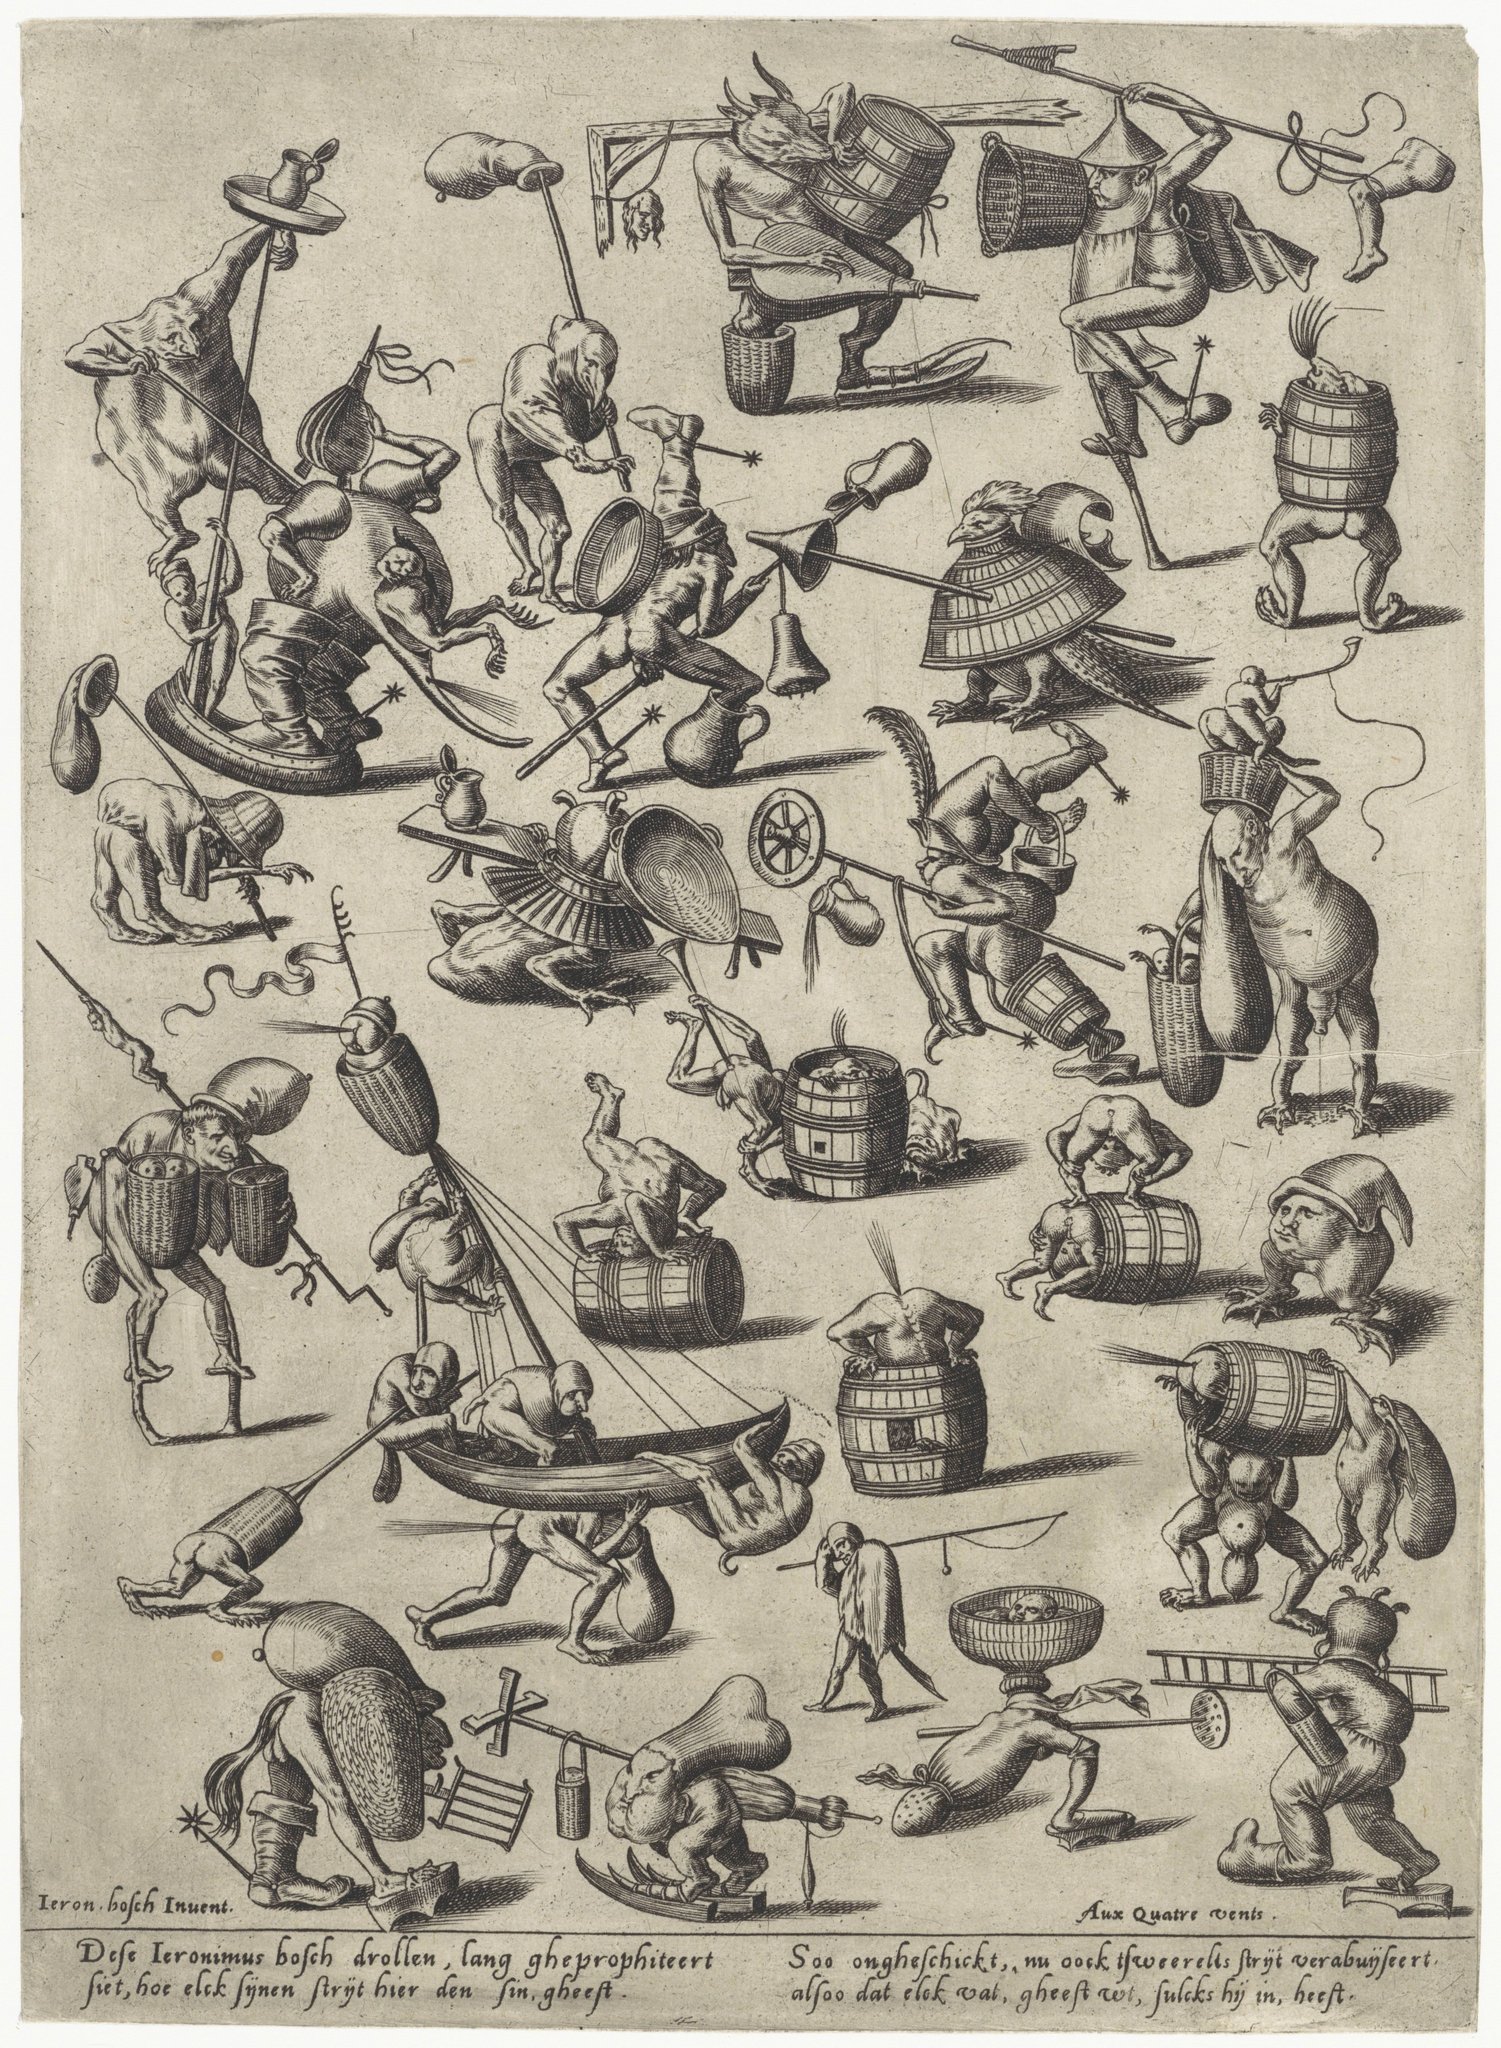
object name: print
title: Verschillende fantasiefiguren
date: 1570-1601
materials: paper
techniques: engraving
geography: den bosch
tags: monsters of mixed human and animal shape; 'mostri' (ripa), human beings (legendary or not) of abnormal proportions, size, strength, etc., anthropomorphic beings (legendary or not) with heads, limbs or organs of an abnormal number, in abnormal places or of an abnormal shape)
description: Verschillende fantasiefiguren met veelal uiterlijke kenmerken van een mens. Sommige wezens hebben ook dierlijke kenmerken. Alle figuren zijn met één of meerdere voorwerpen afgebeeld, zoals een ton, een hengel en een boot. Onder de voorstelling in de marge een vierregelige tekst in het Nederlands.